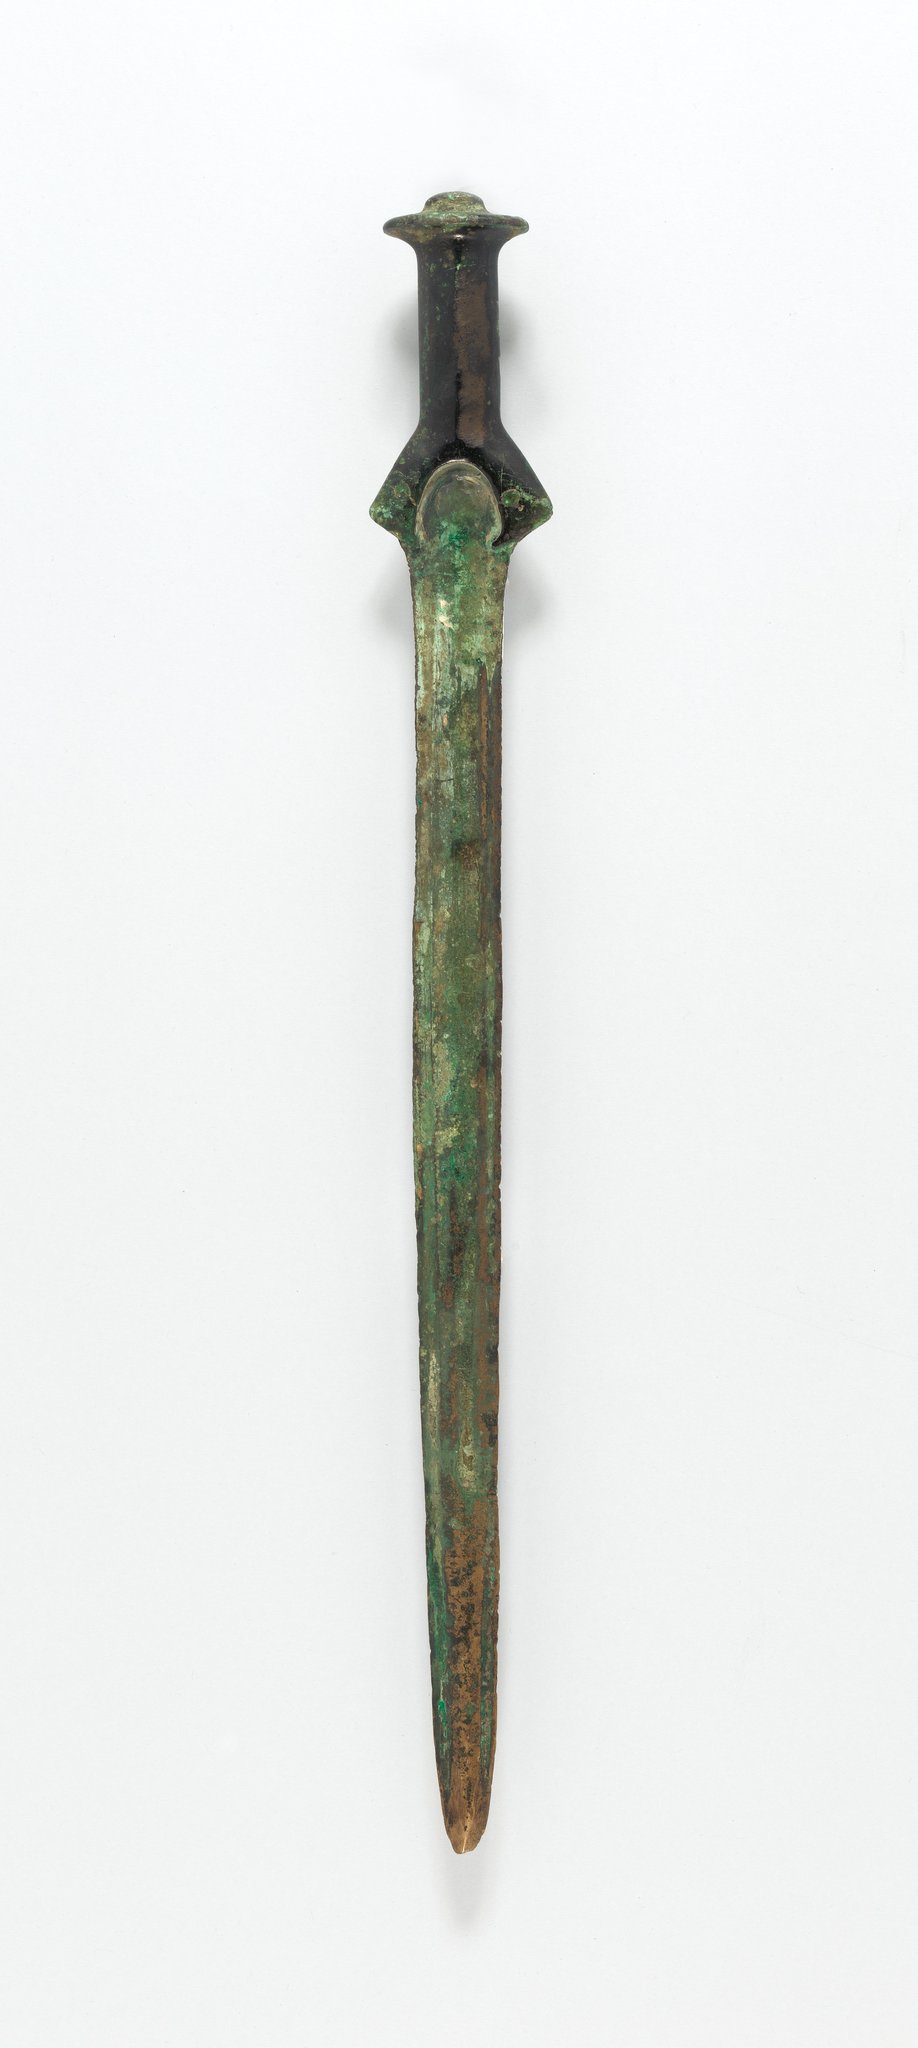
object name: sword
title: Sword of the Achtkantschwert Type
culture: central european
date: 1300-1201 BCE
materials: bronze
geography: probably central europe